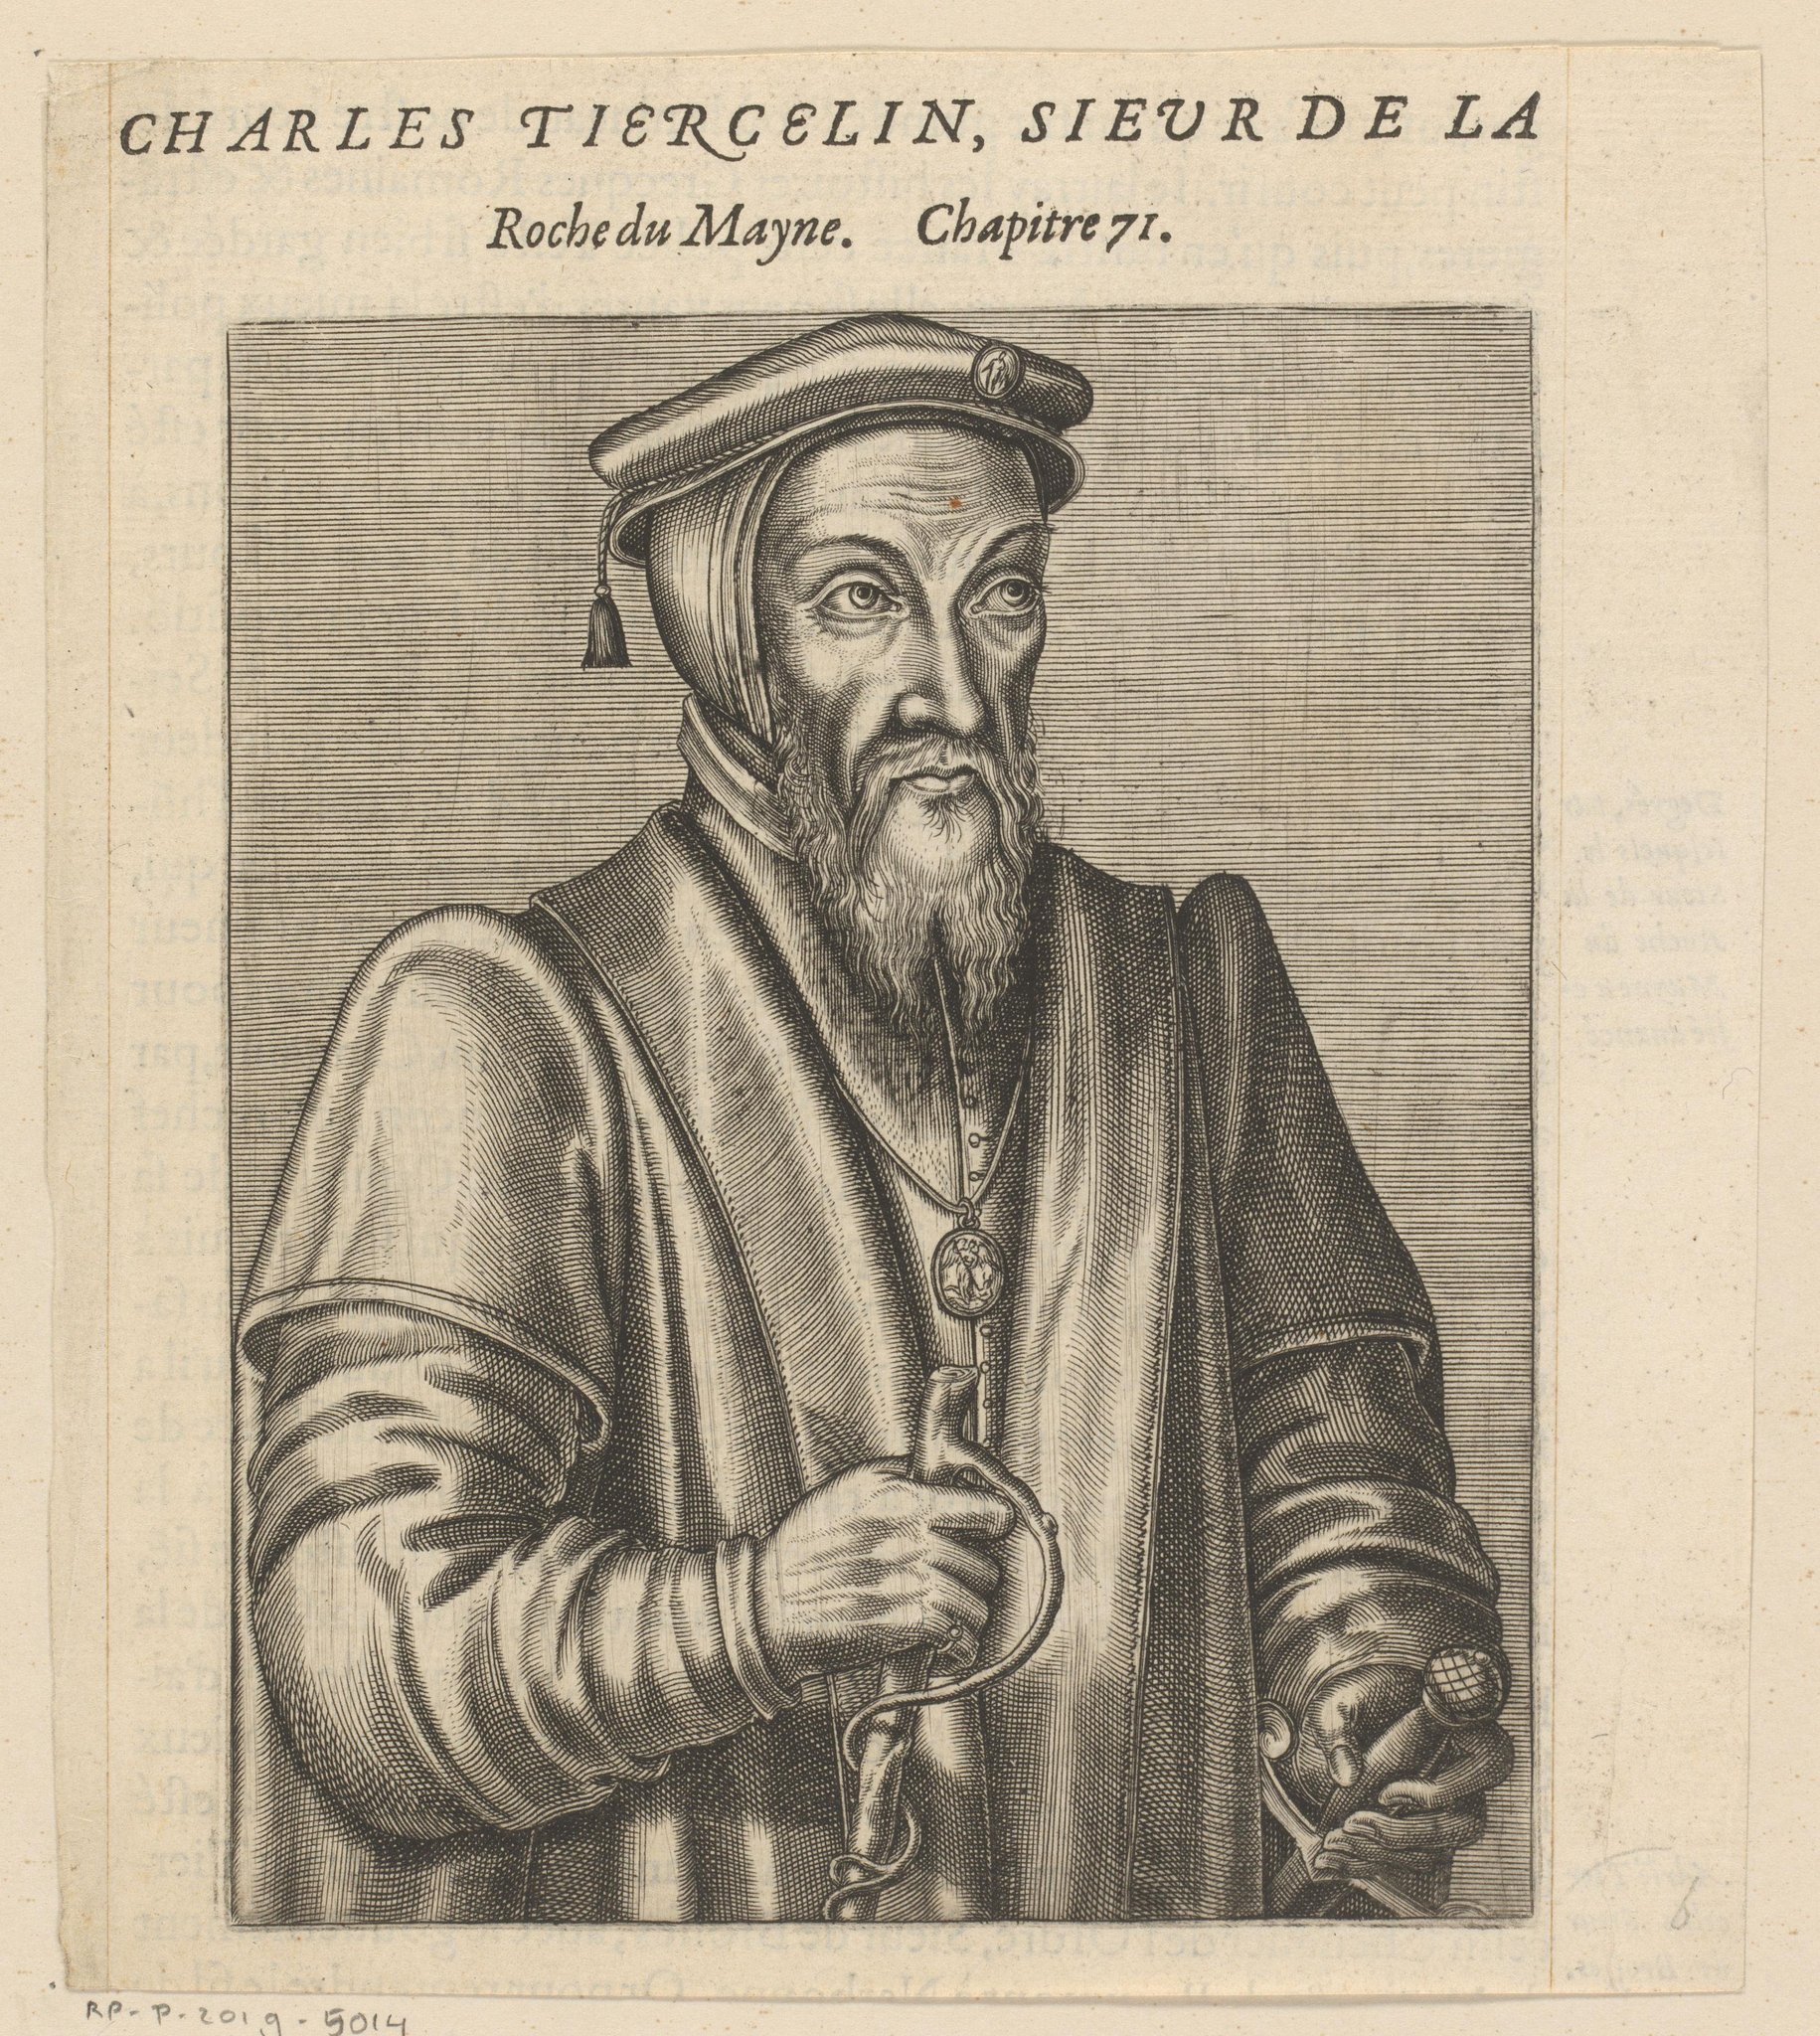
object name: book illustration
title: Portret van Charles Tiercelin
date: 1584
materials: paper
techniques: engraving, etching, letterpress printing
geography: paris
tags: historical persons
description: Prent uit: Thevet, André. Les vrais pourtraits et vies des hommes illustres grecz, latins et payens (...). Parijs: weduwe Jacques Kerver en Guillaume Chaudière, 1584, dl. 2, f. 438.